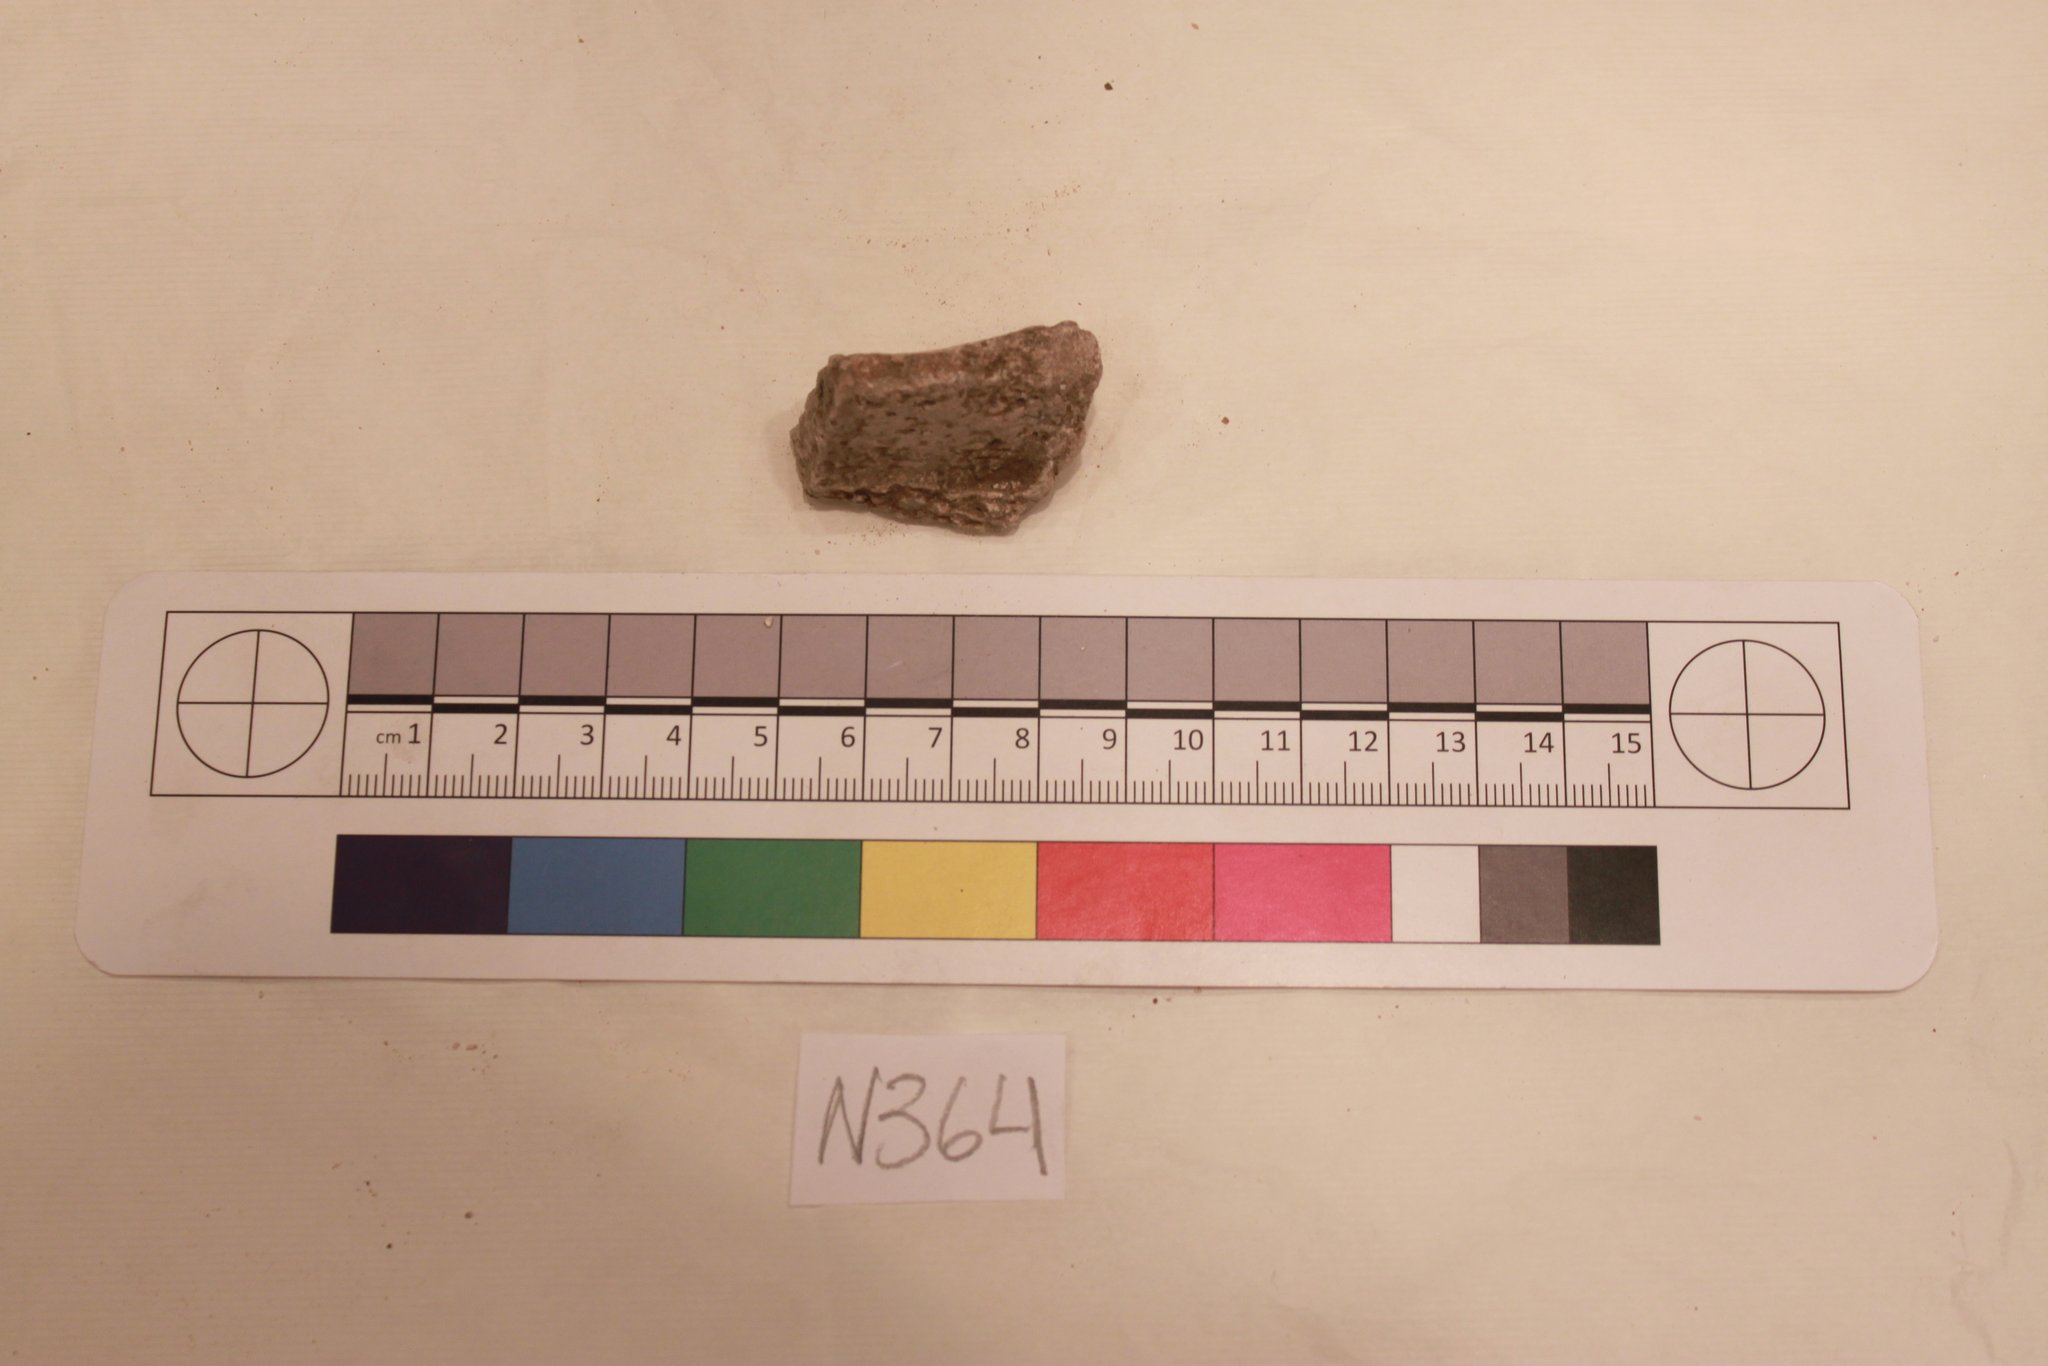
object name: fragment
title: Stucco Fragment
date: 701-1200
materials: plaster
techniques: carving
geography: iran